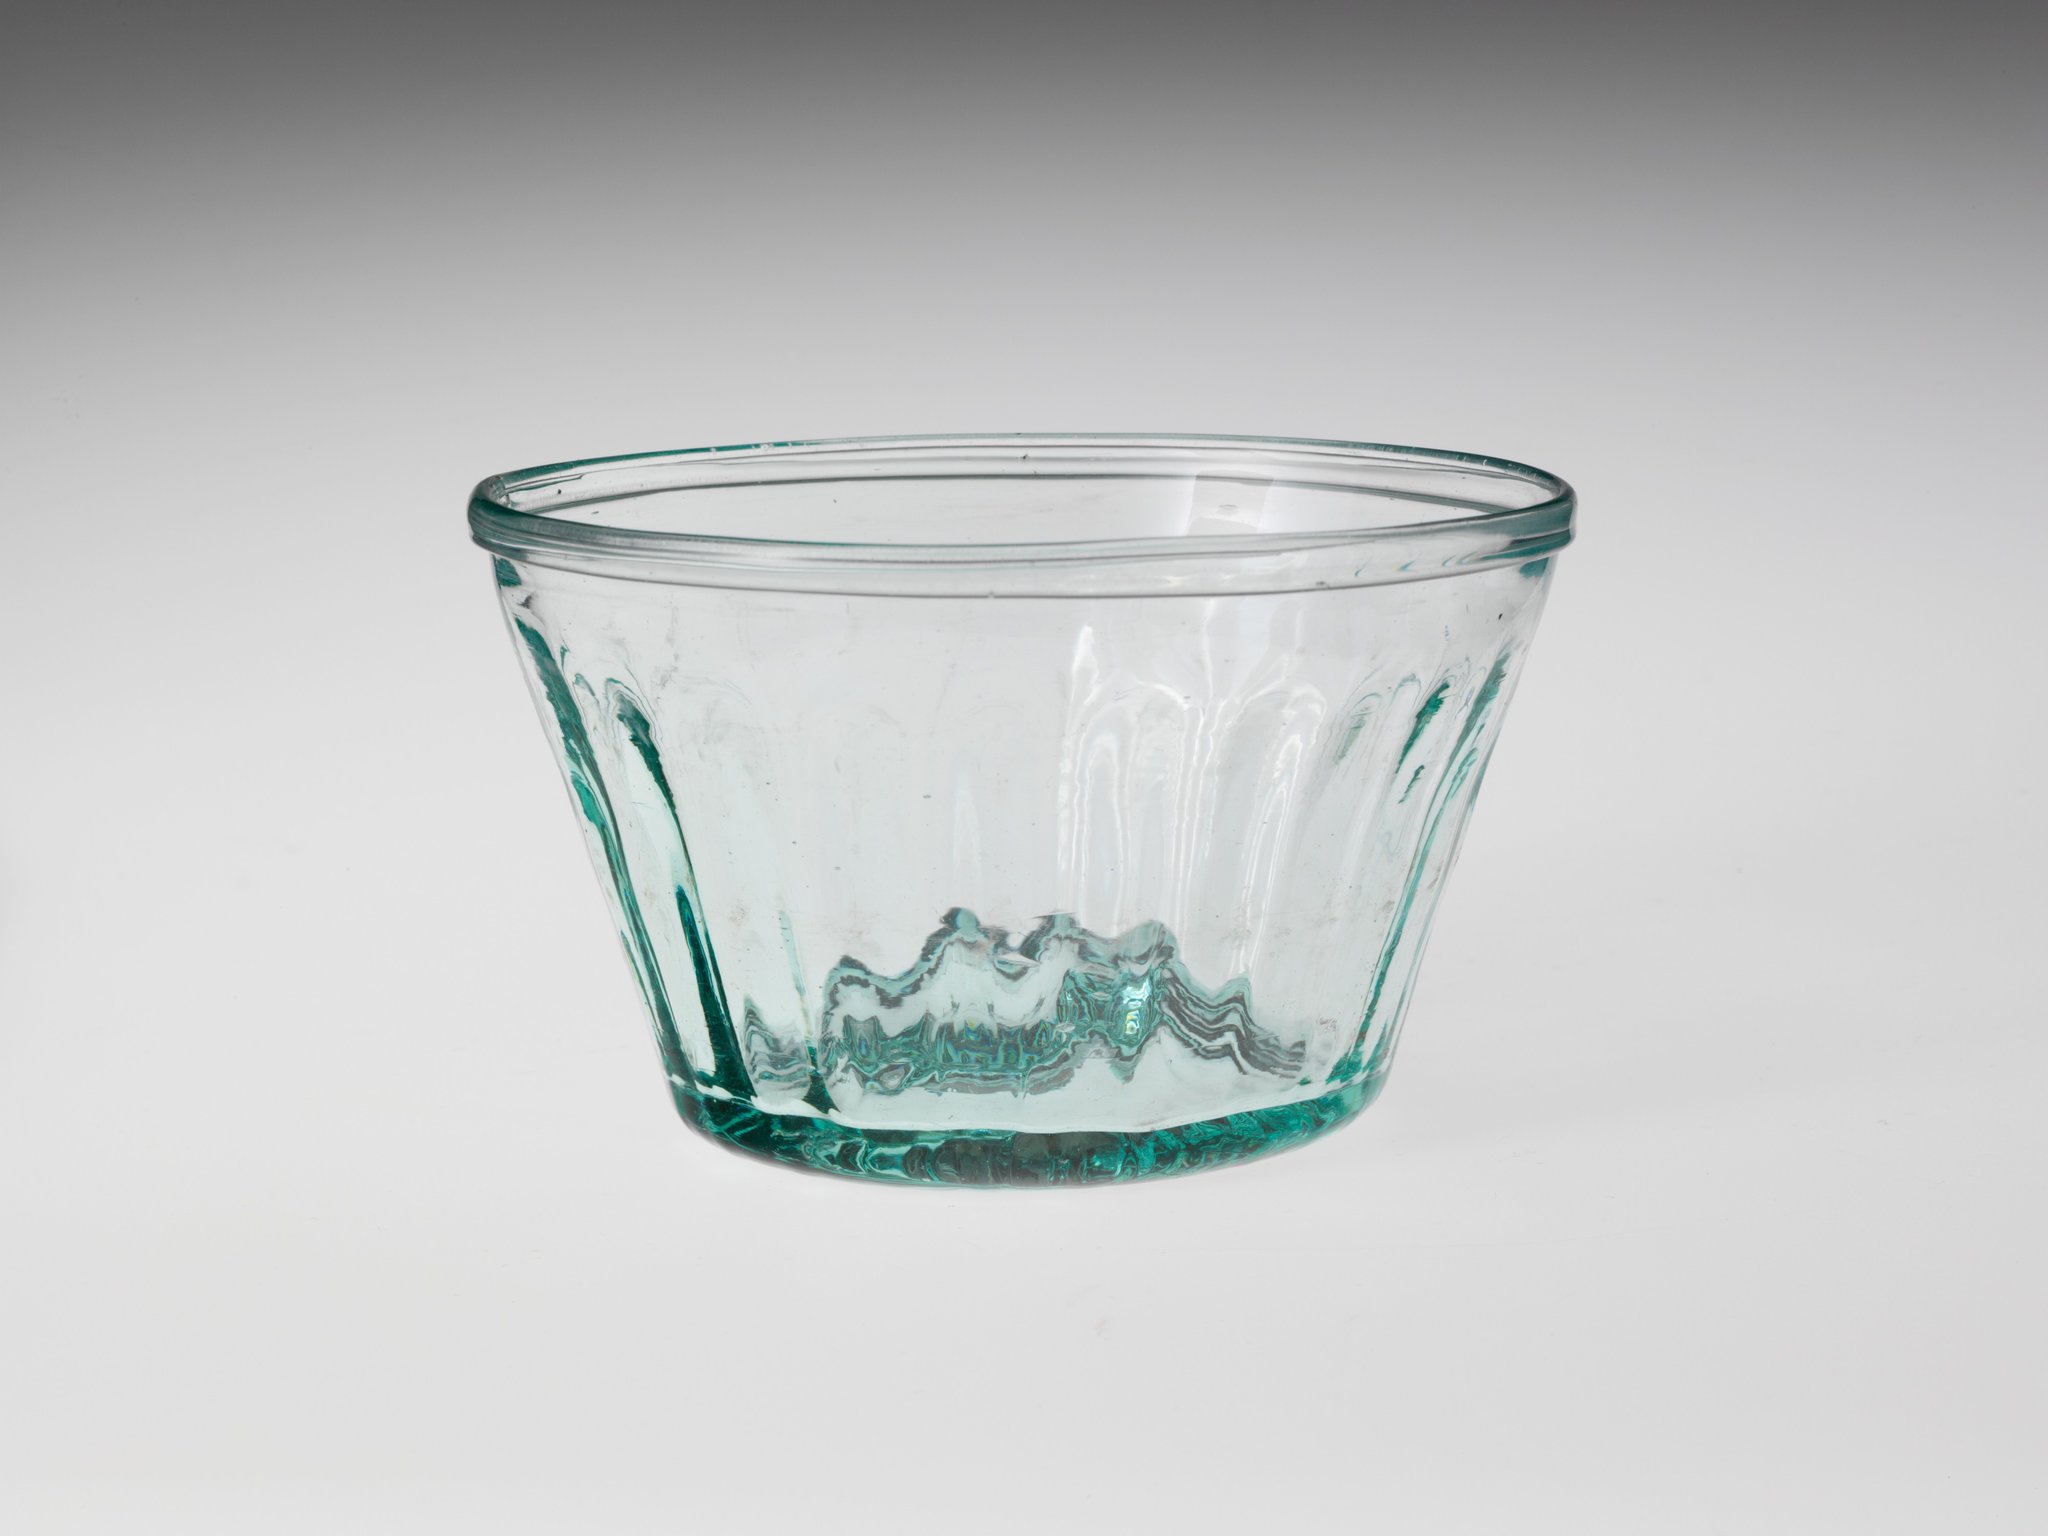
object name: bowl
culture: american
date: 1800-1830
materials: glass, lead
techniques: glassblowing, molding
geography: united states